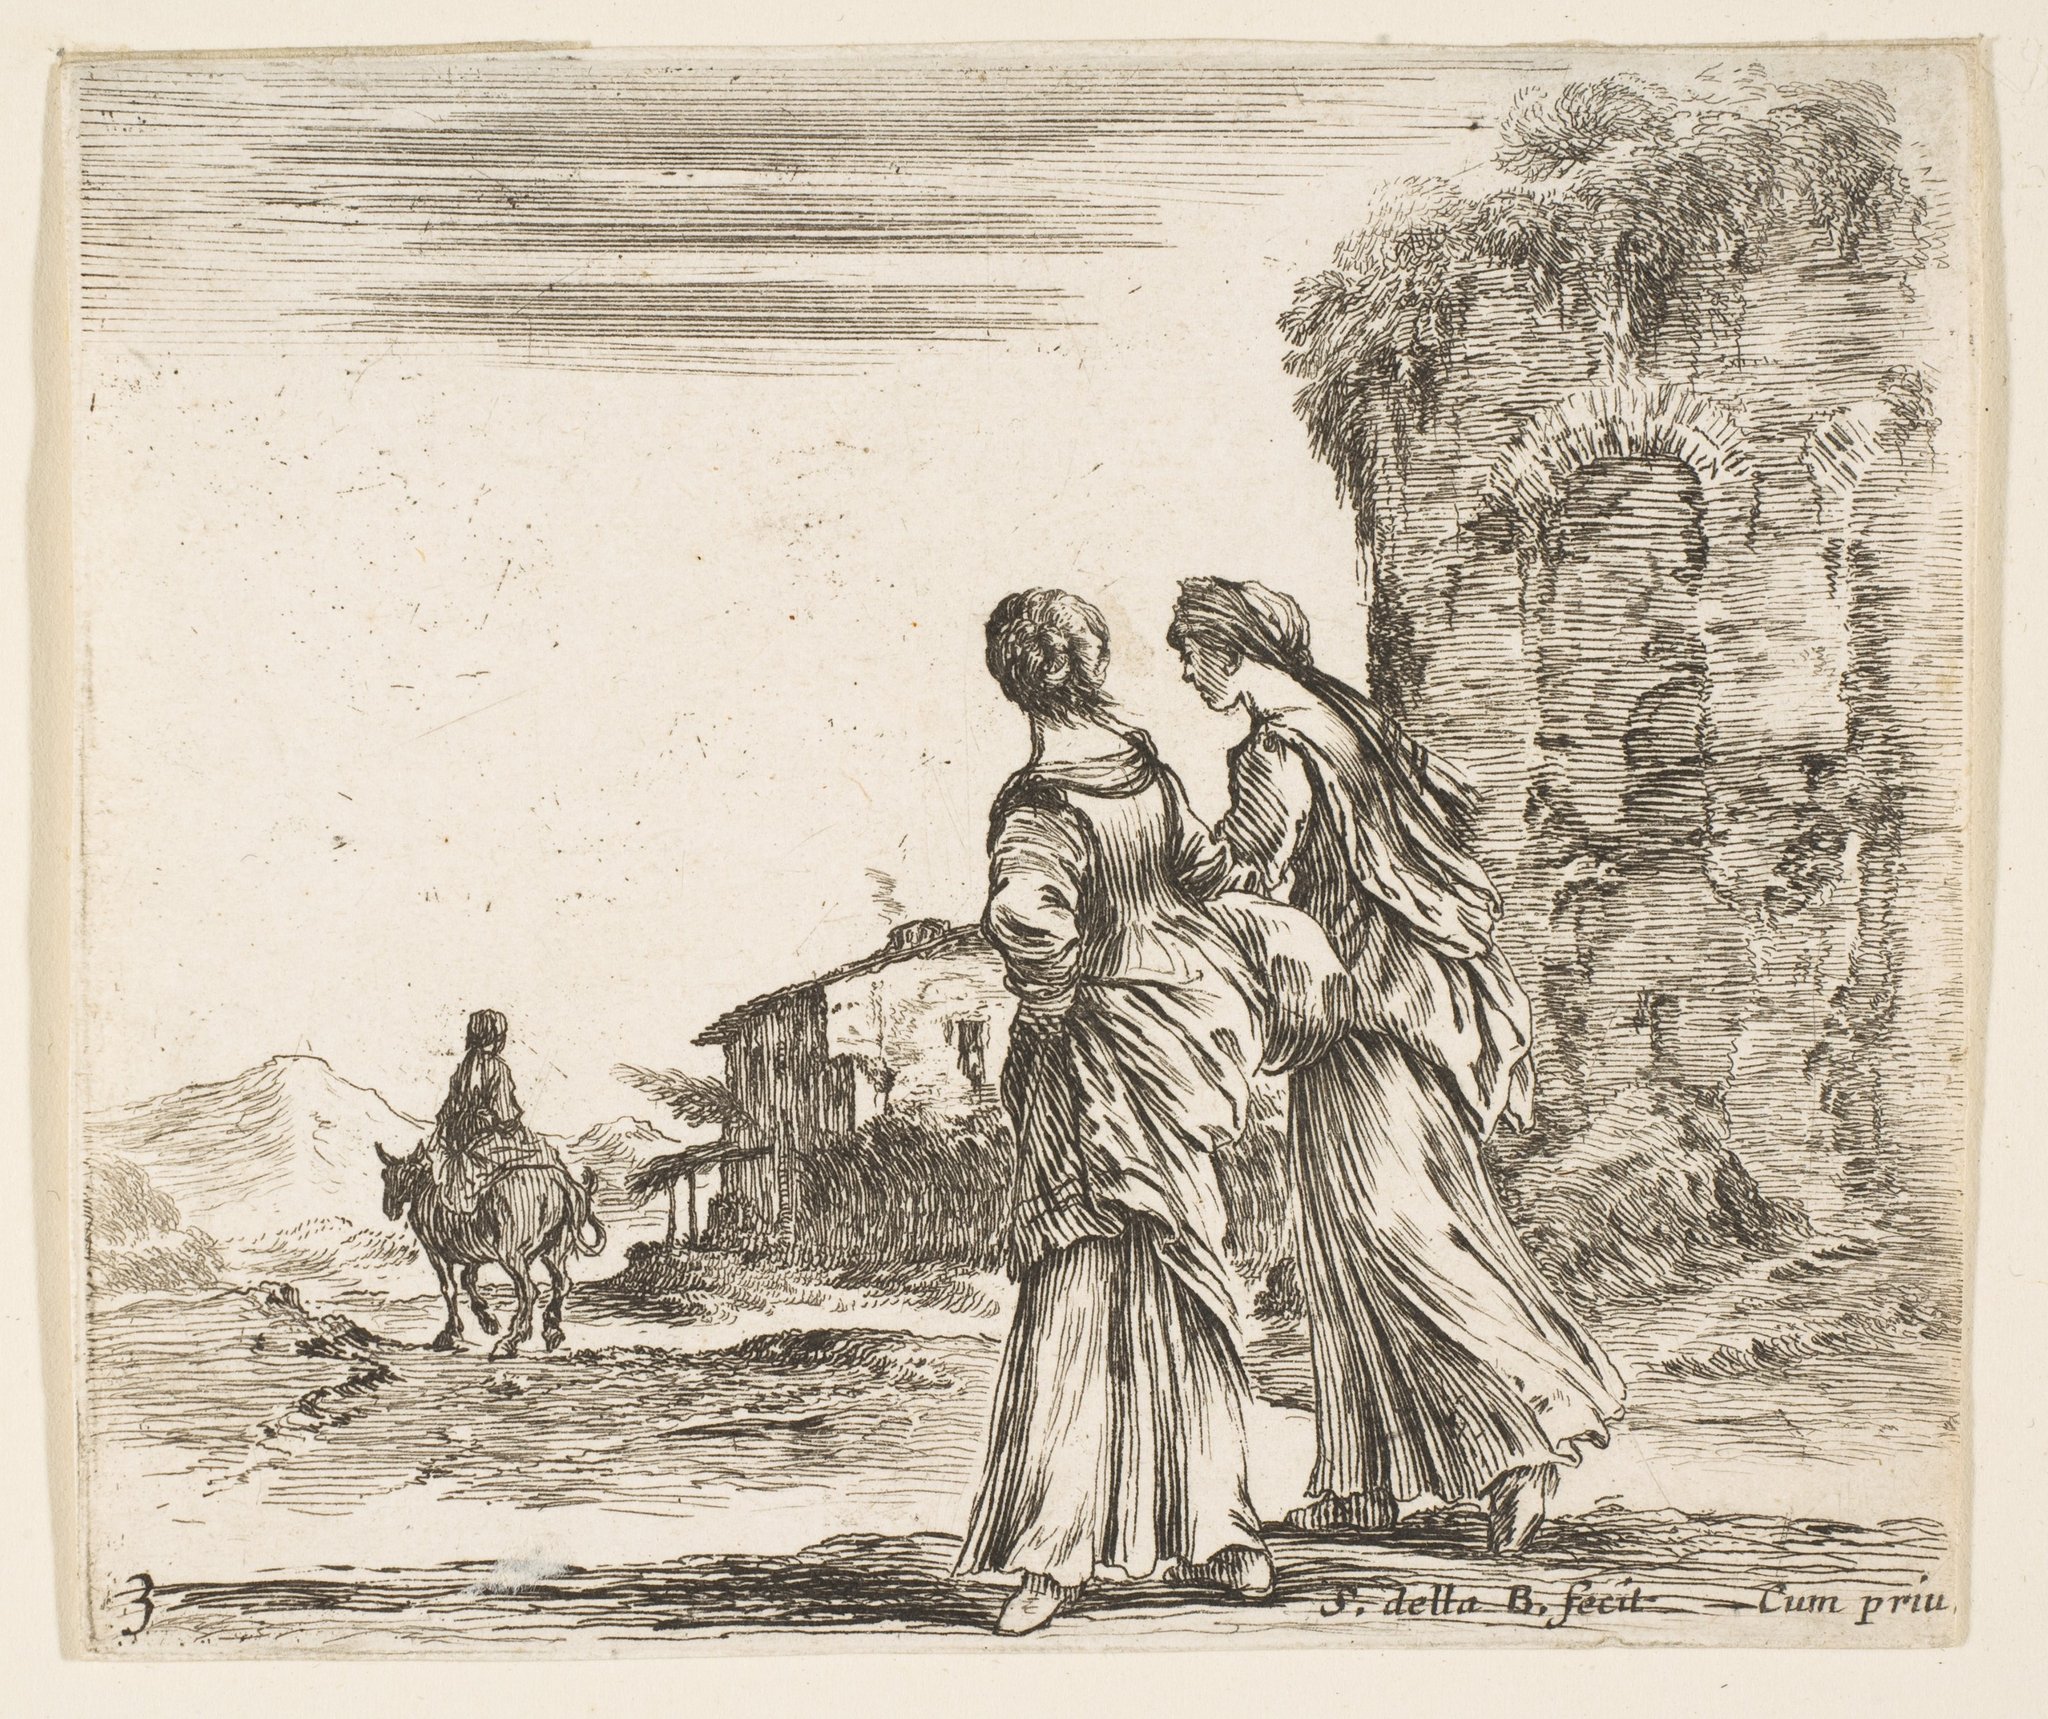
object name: print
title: Two girls walking towards the left, seen from behind, a woman on a horse to left in background, plate 3 from "Diversi capricci"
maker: stefano della bella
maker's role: artist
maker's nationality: italian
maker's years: 1610-1664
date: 1644-1647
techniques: etching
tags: girls,women,horses